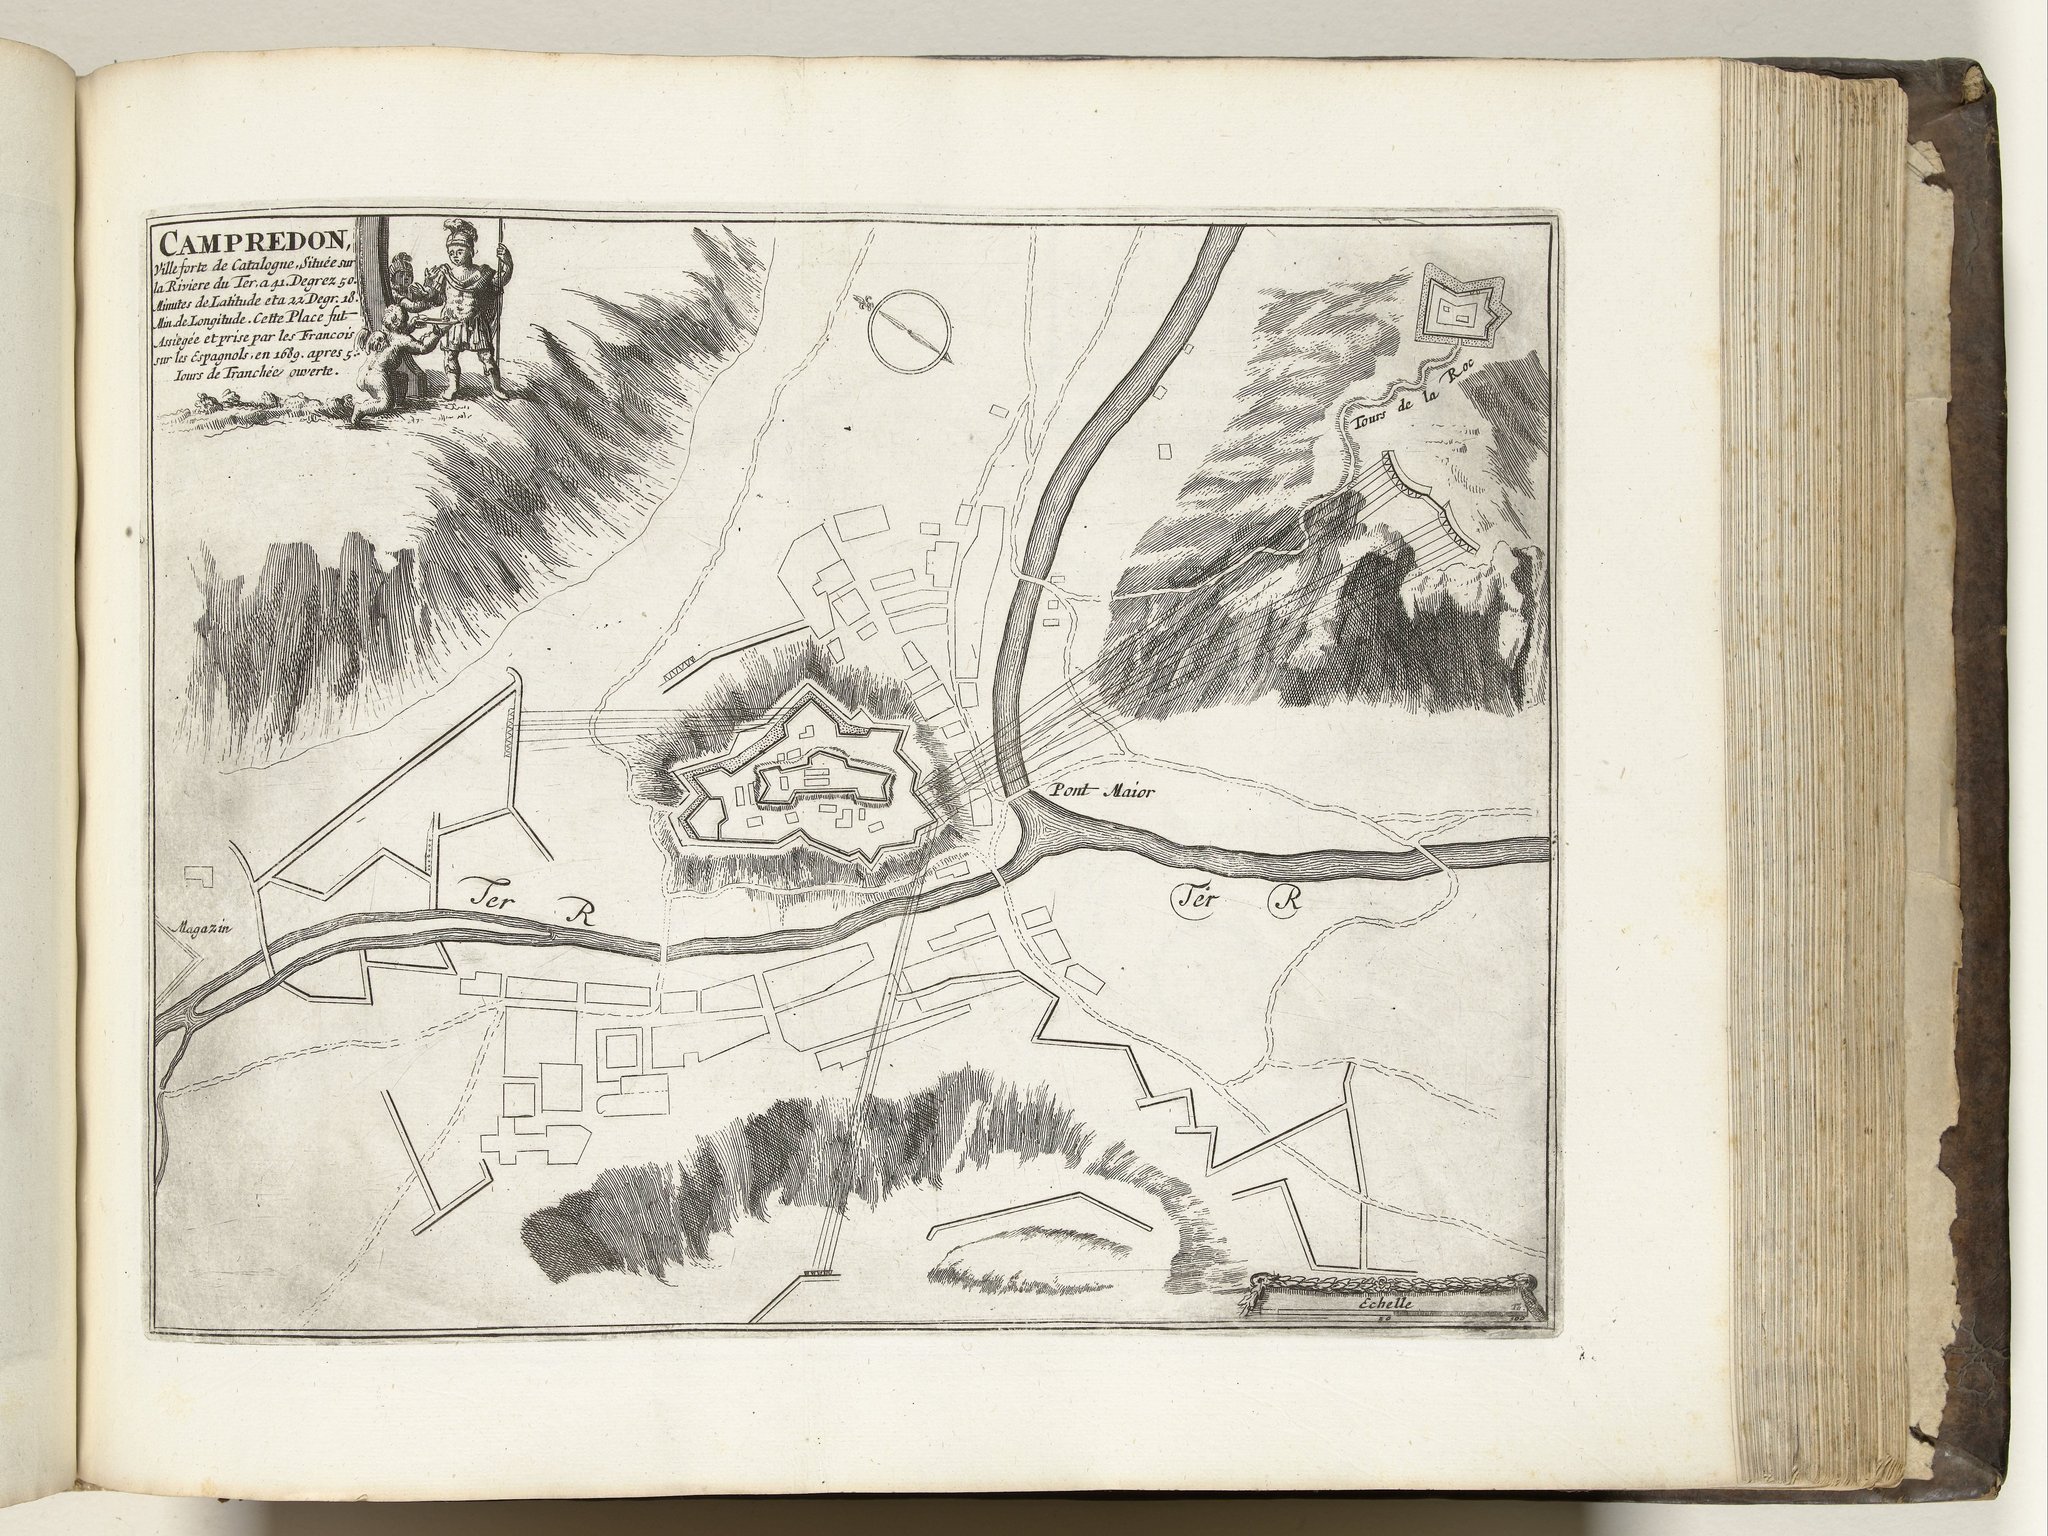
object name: map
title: Les forces de l'Europe, ou description des principales villes, avec leurs fortifications : dessignées par les meilleurs ingenieurs, particulierement celles (...) de la France, dont les plans ont esté levez par M. de Vauban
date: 1693-1696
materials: paper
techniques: etching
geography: france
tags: siege, position war, maps of cities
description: Beleg van het Spaanse fort Campredon in Calatonië aan de rivier Ter door het Franse leger, veroverd in 1689. Onderdeel van het zesde deel (1696) van het prentwerk waarin gebundeld zijn de acht delen van Les forces de l'Europe uitgegeven tussen 1693-1697. Het prentwerk bestaat uit 175 platen met plannen (afkomstig van Sébastien Le Prestre, Seigneur de Vauban) van vermaarde sterke steden en vestingen in de Negenjarige Oorlog. Titel en opschriften in het Frans.